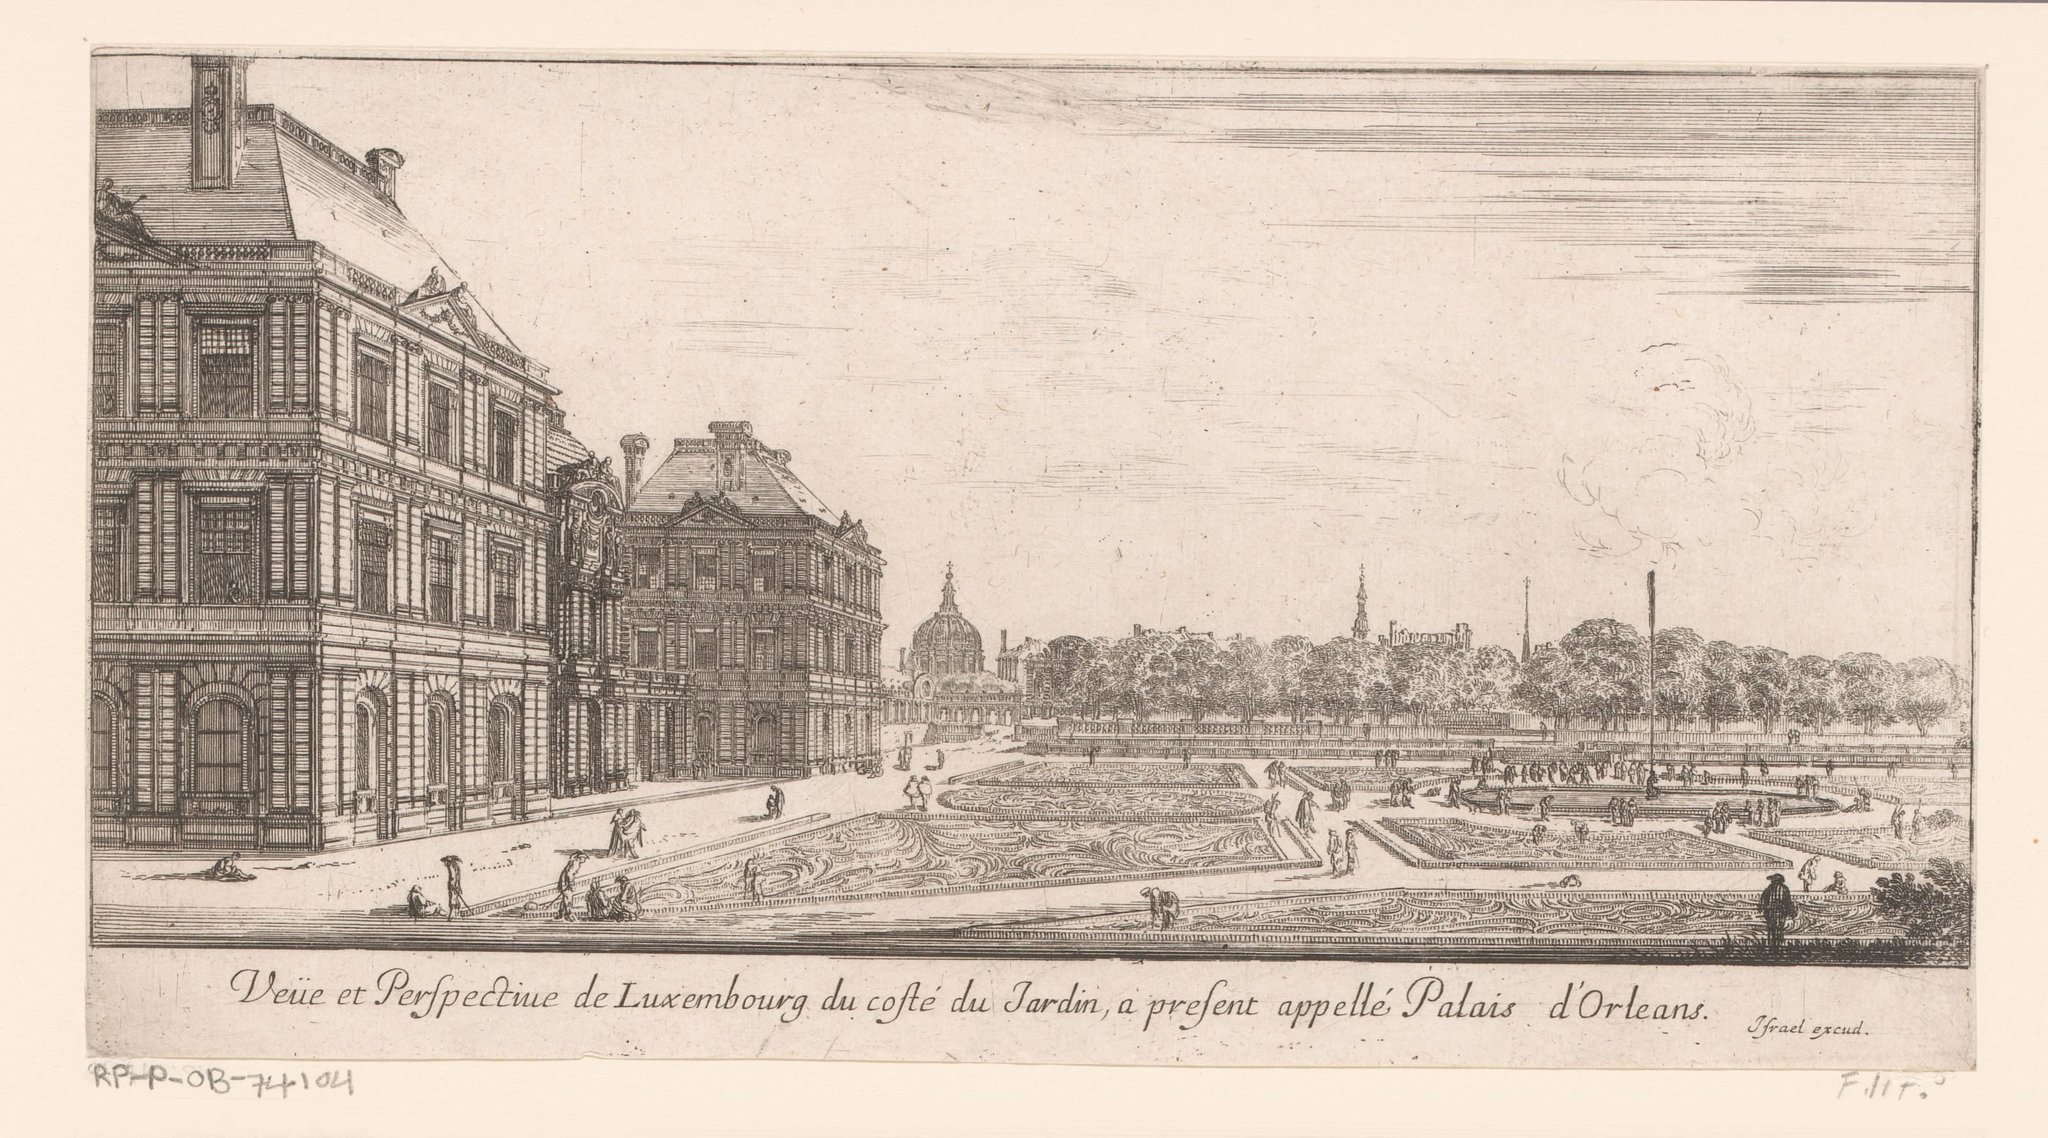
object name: print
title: Veue et Perspective de Luxembourg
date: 1631-1661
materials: paper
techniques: etching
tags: palace, french or architectonic garden; formal garden